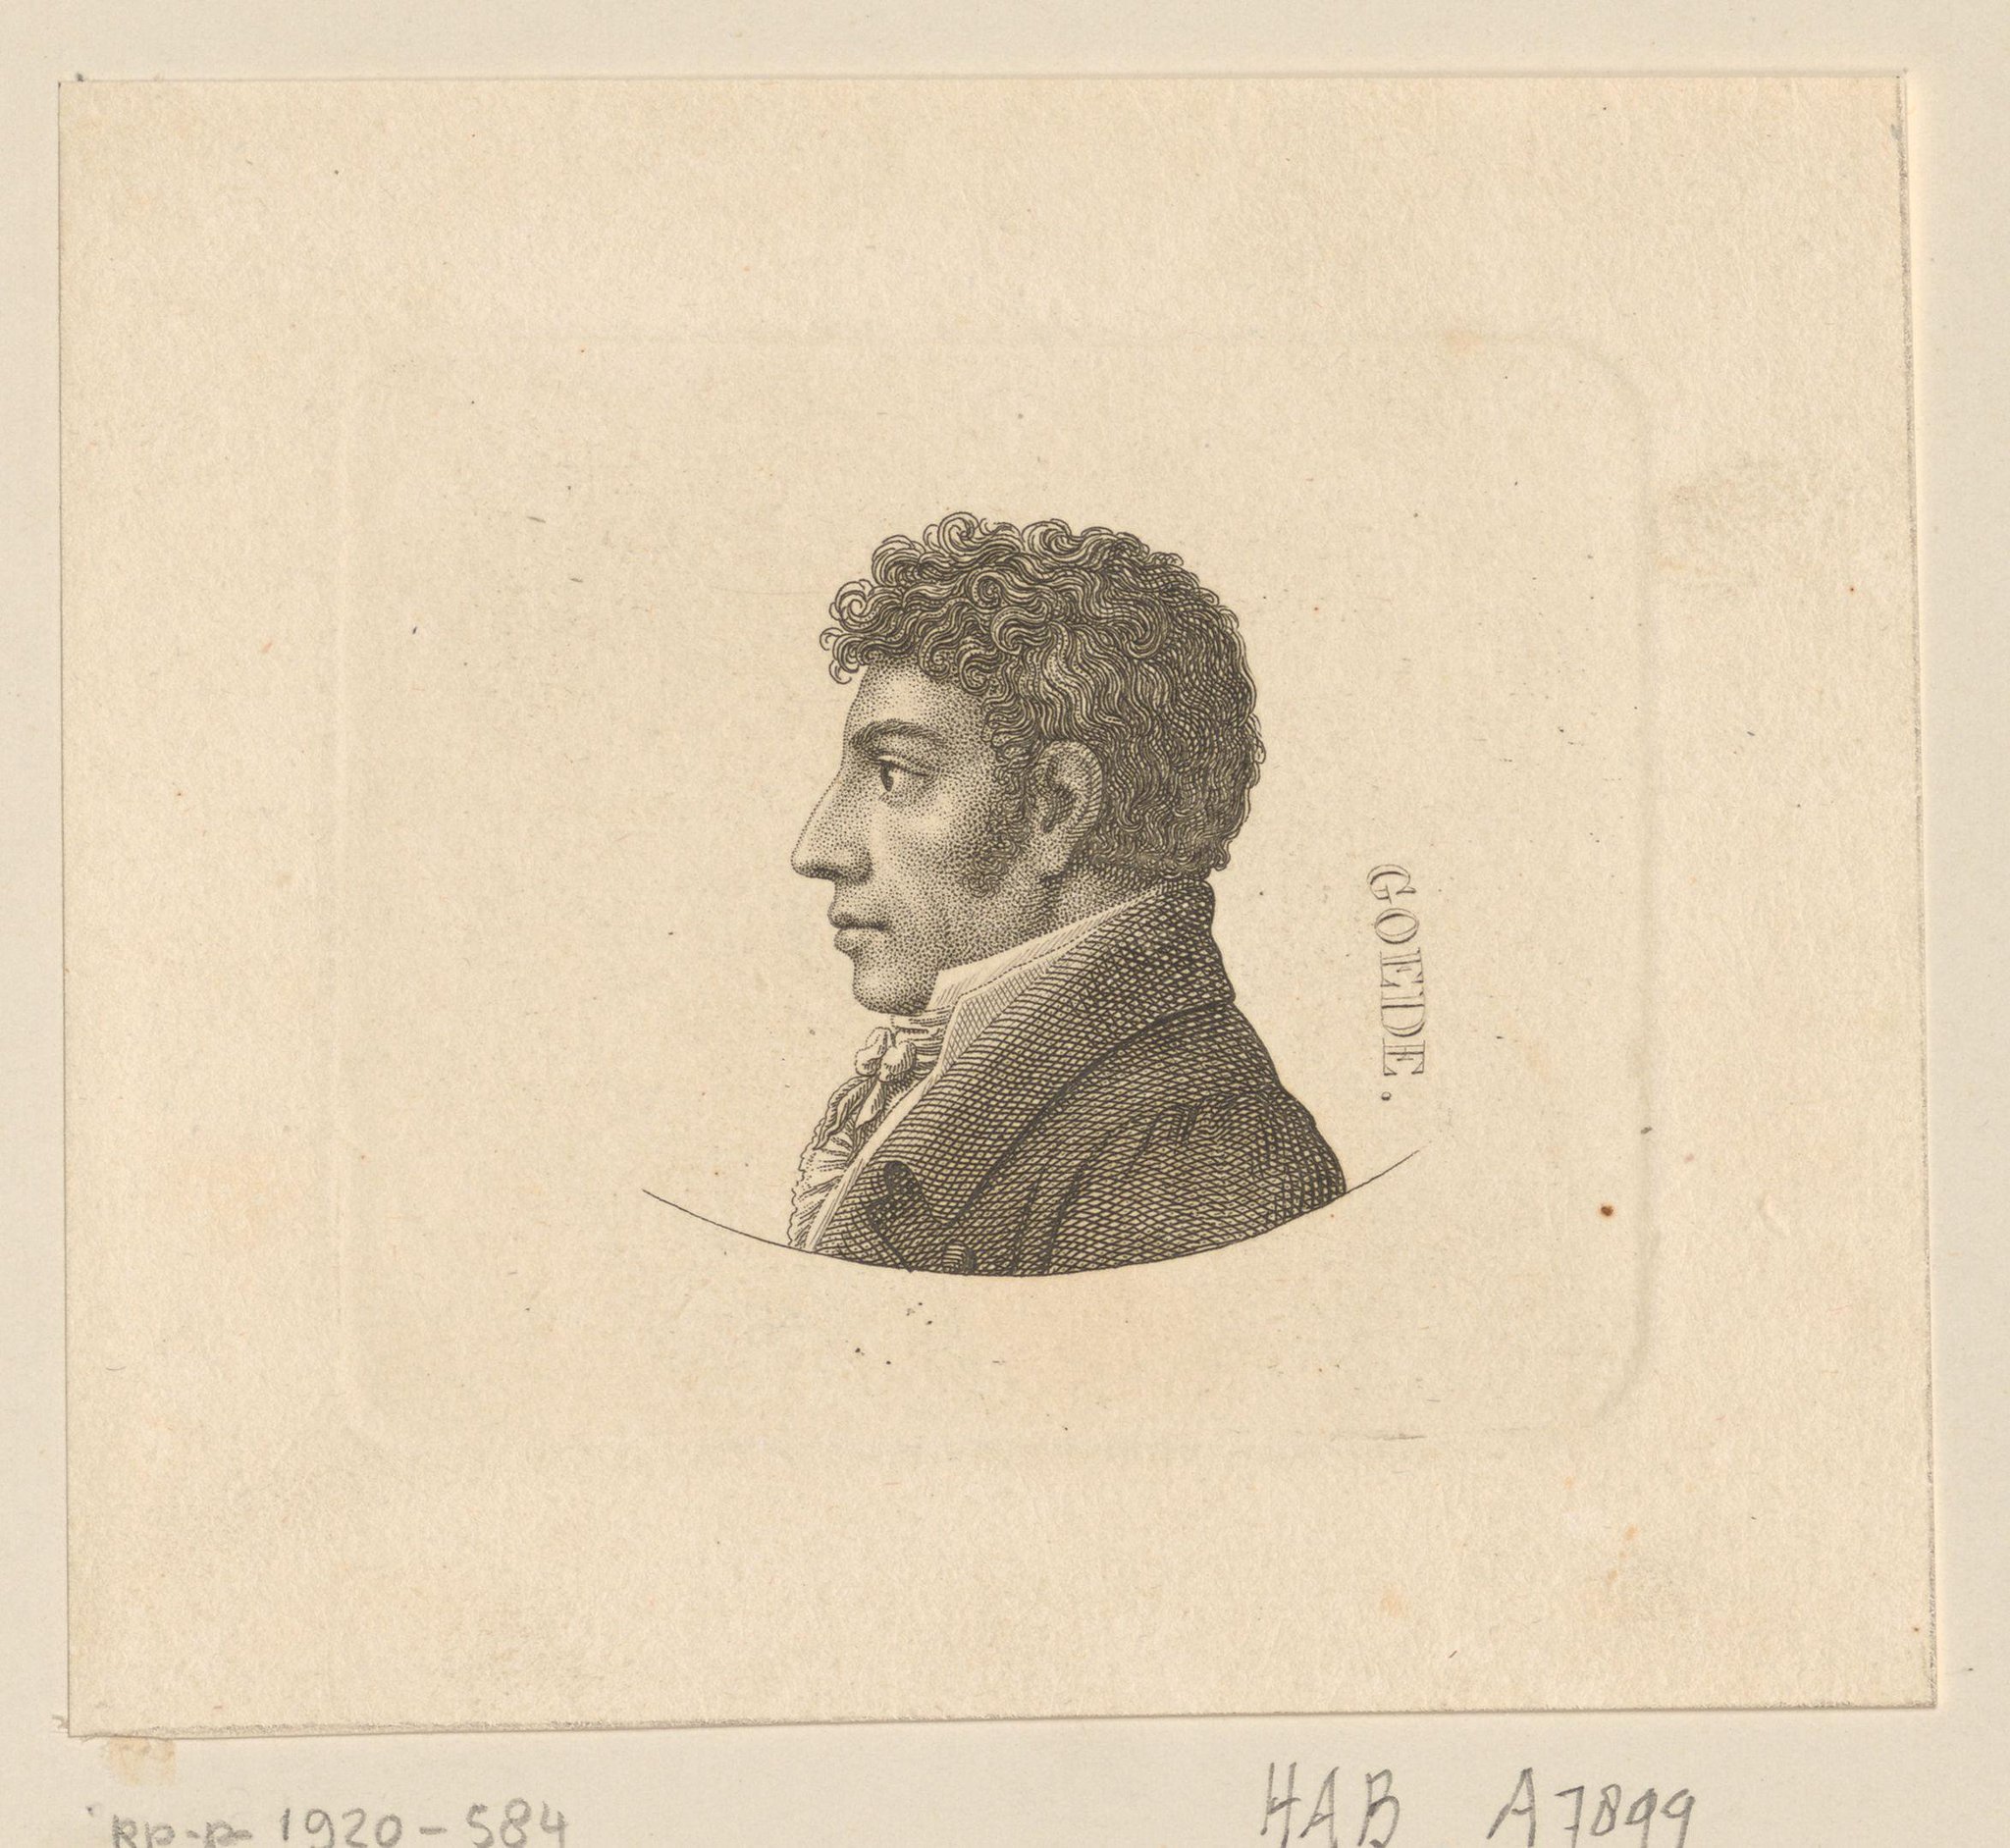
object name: print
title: Portret van Christian August Gottlieb Göde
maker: ernst ludwig riepenhausen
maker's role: print maker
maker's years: 1765-1840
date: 1794-1812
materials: paper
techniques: engraving, etching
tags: historical persons, portrait of a writer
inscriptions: collector's mark: Lugt 2228